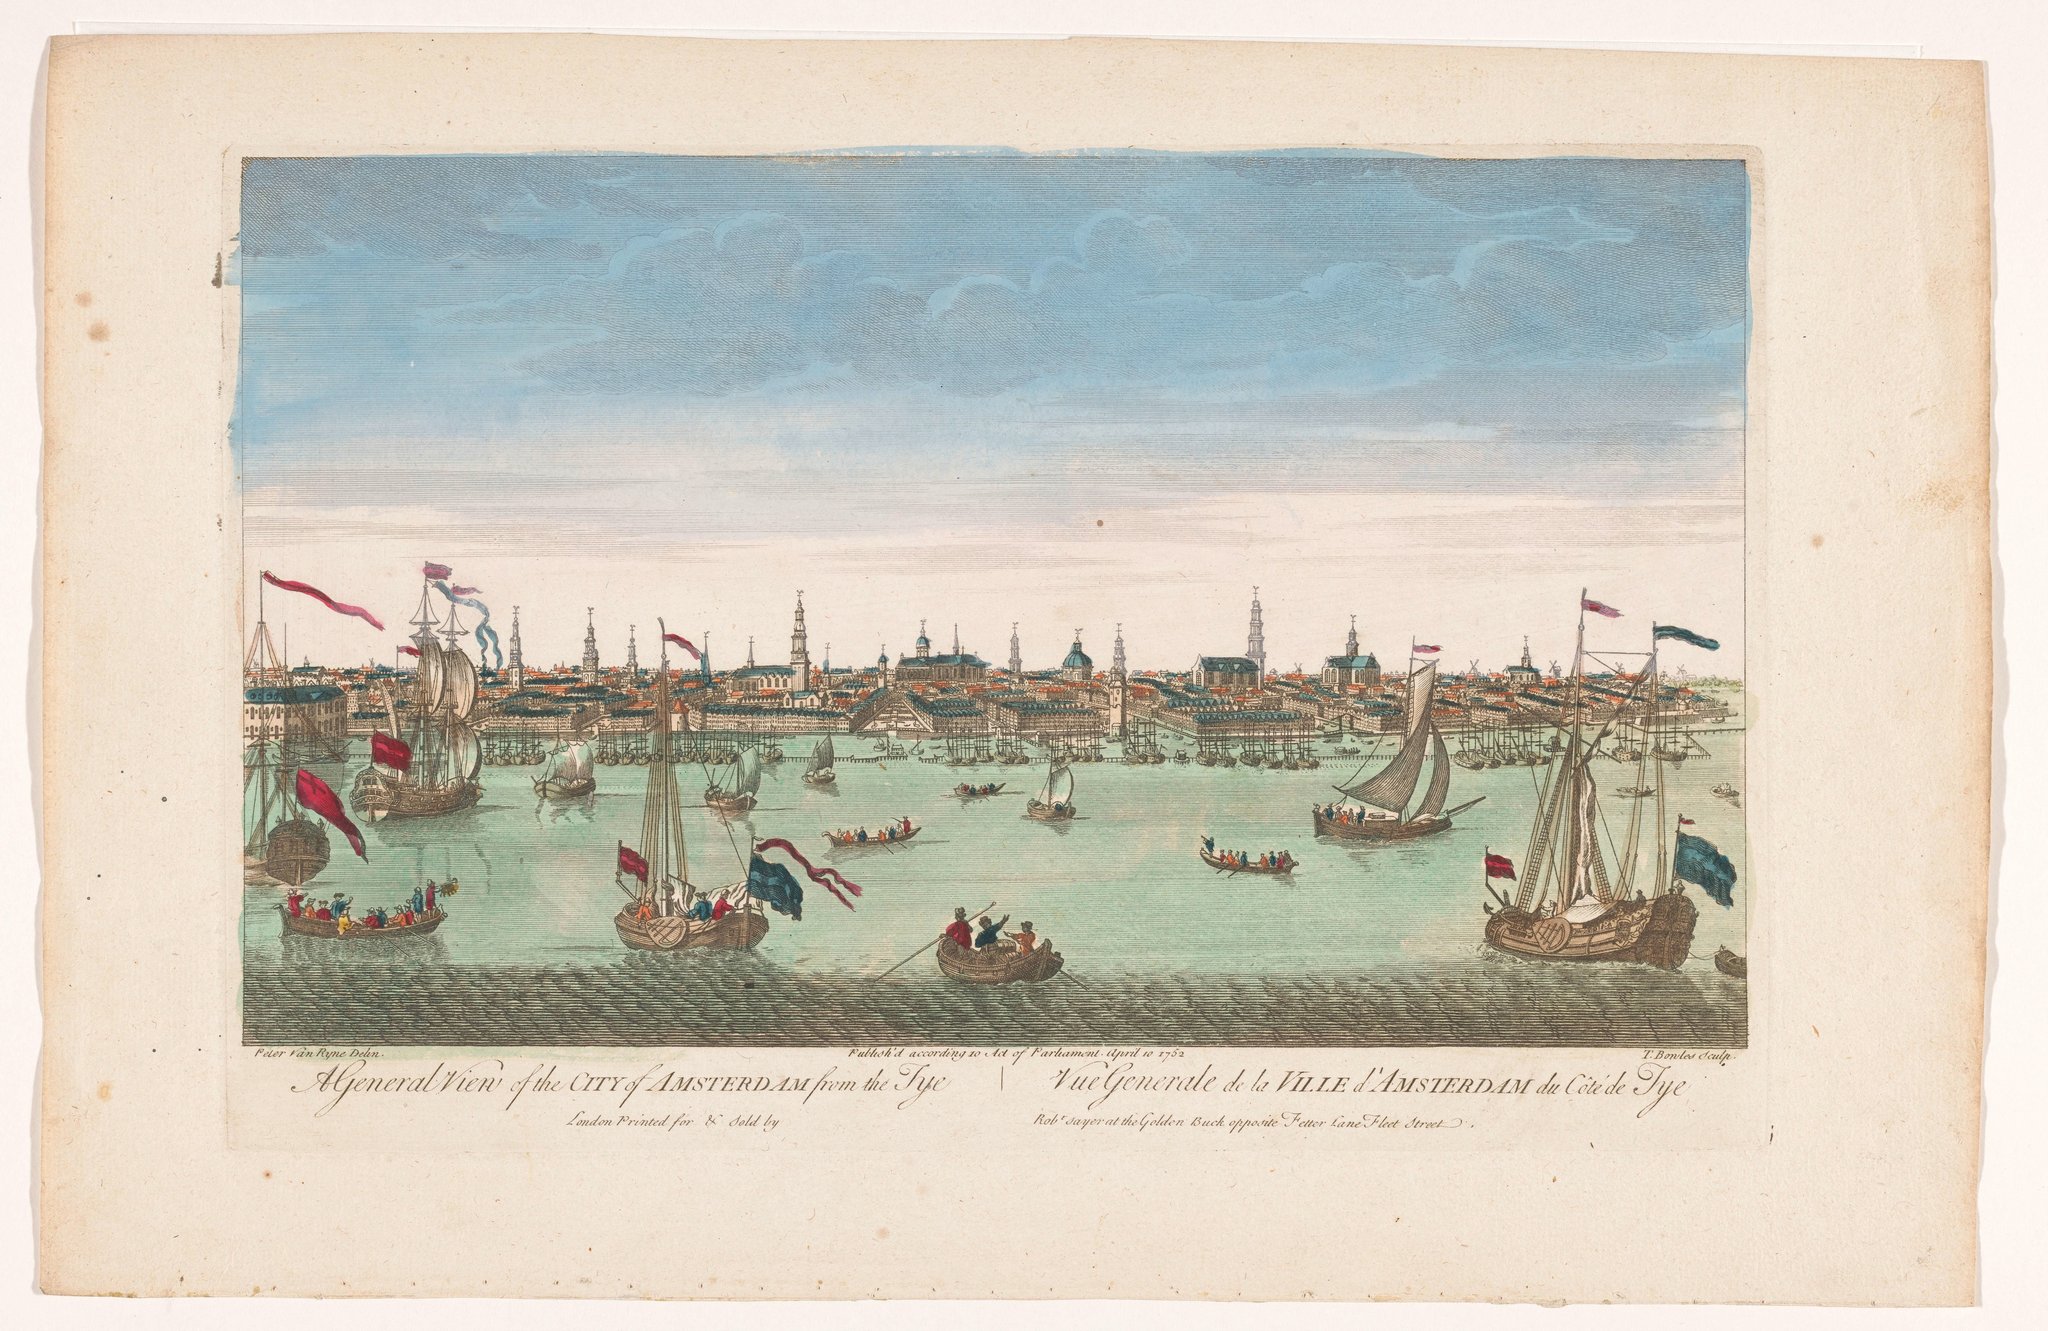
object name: opticaprent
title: Gezicht op de stad Amsterdam gezien vanaf het IJ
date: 1752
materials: paper, watercolor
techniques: brush, etching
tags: sailing-ship, sailing-boat, tower, clock tower ~ monumental adornment, church (exterior), rowing-boat, canoe, etc., city-view in general; 'veduta' (+ city(-scape) with figures, staffage), canals, waters (in city) (+ city(-scape) with figures, staffage), amsterdam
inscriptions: watermark, collector's mark: Lugt 2166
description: De signaturen van de uitgever Robert Sayer, van de prentmaker Thomas Bowles en mogelijk ook de datering zijn mee gekopieerd.